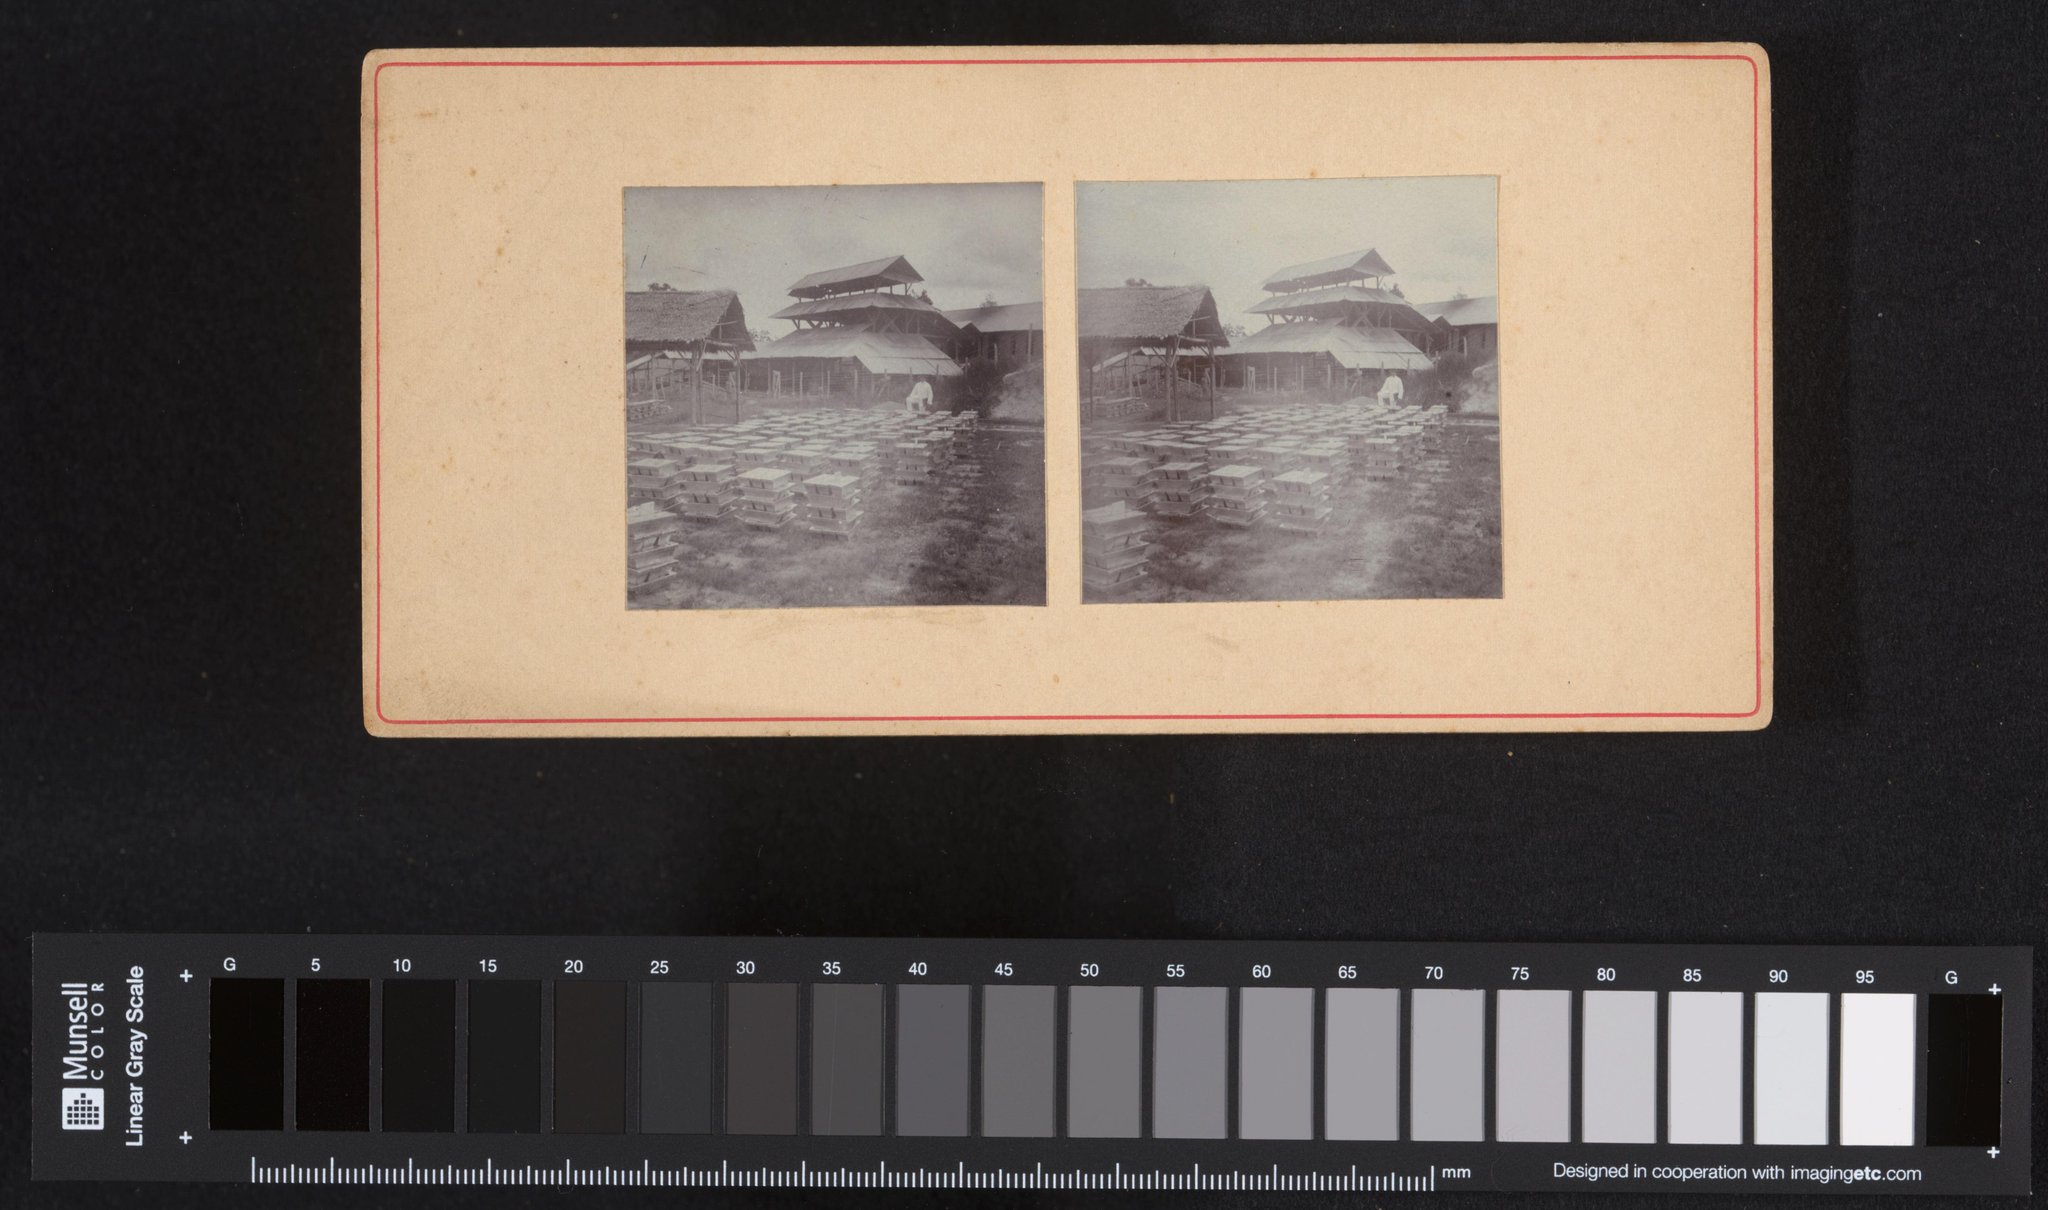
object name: stereograph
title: Opslagplaats voor tin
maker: robert julius boers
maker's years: 1867-1932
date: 1900-1922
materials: cardboard, photographic support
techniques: gelatin silver print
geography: bangka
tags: robert julius boers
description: Opslagplaats met opgestapelde broodjes tin, te Banka. Onderdeel van een groep stereofoto's van Robert Julius Boers, chef van het staatsbedrijf de Banka-tinwinning op Banka, uit de periode ca. 1900-1922.